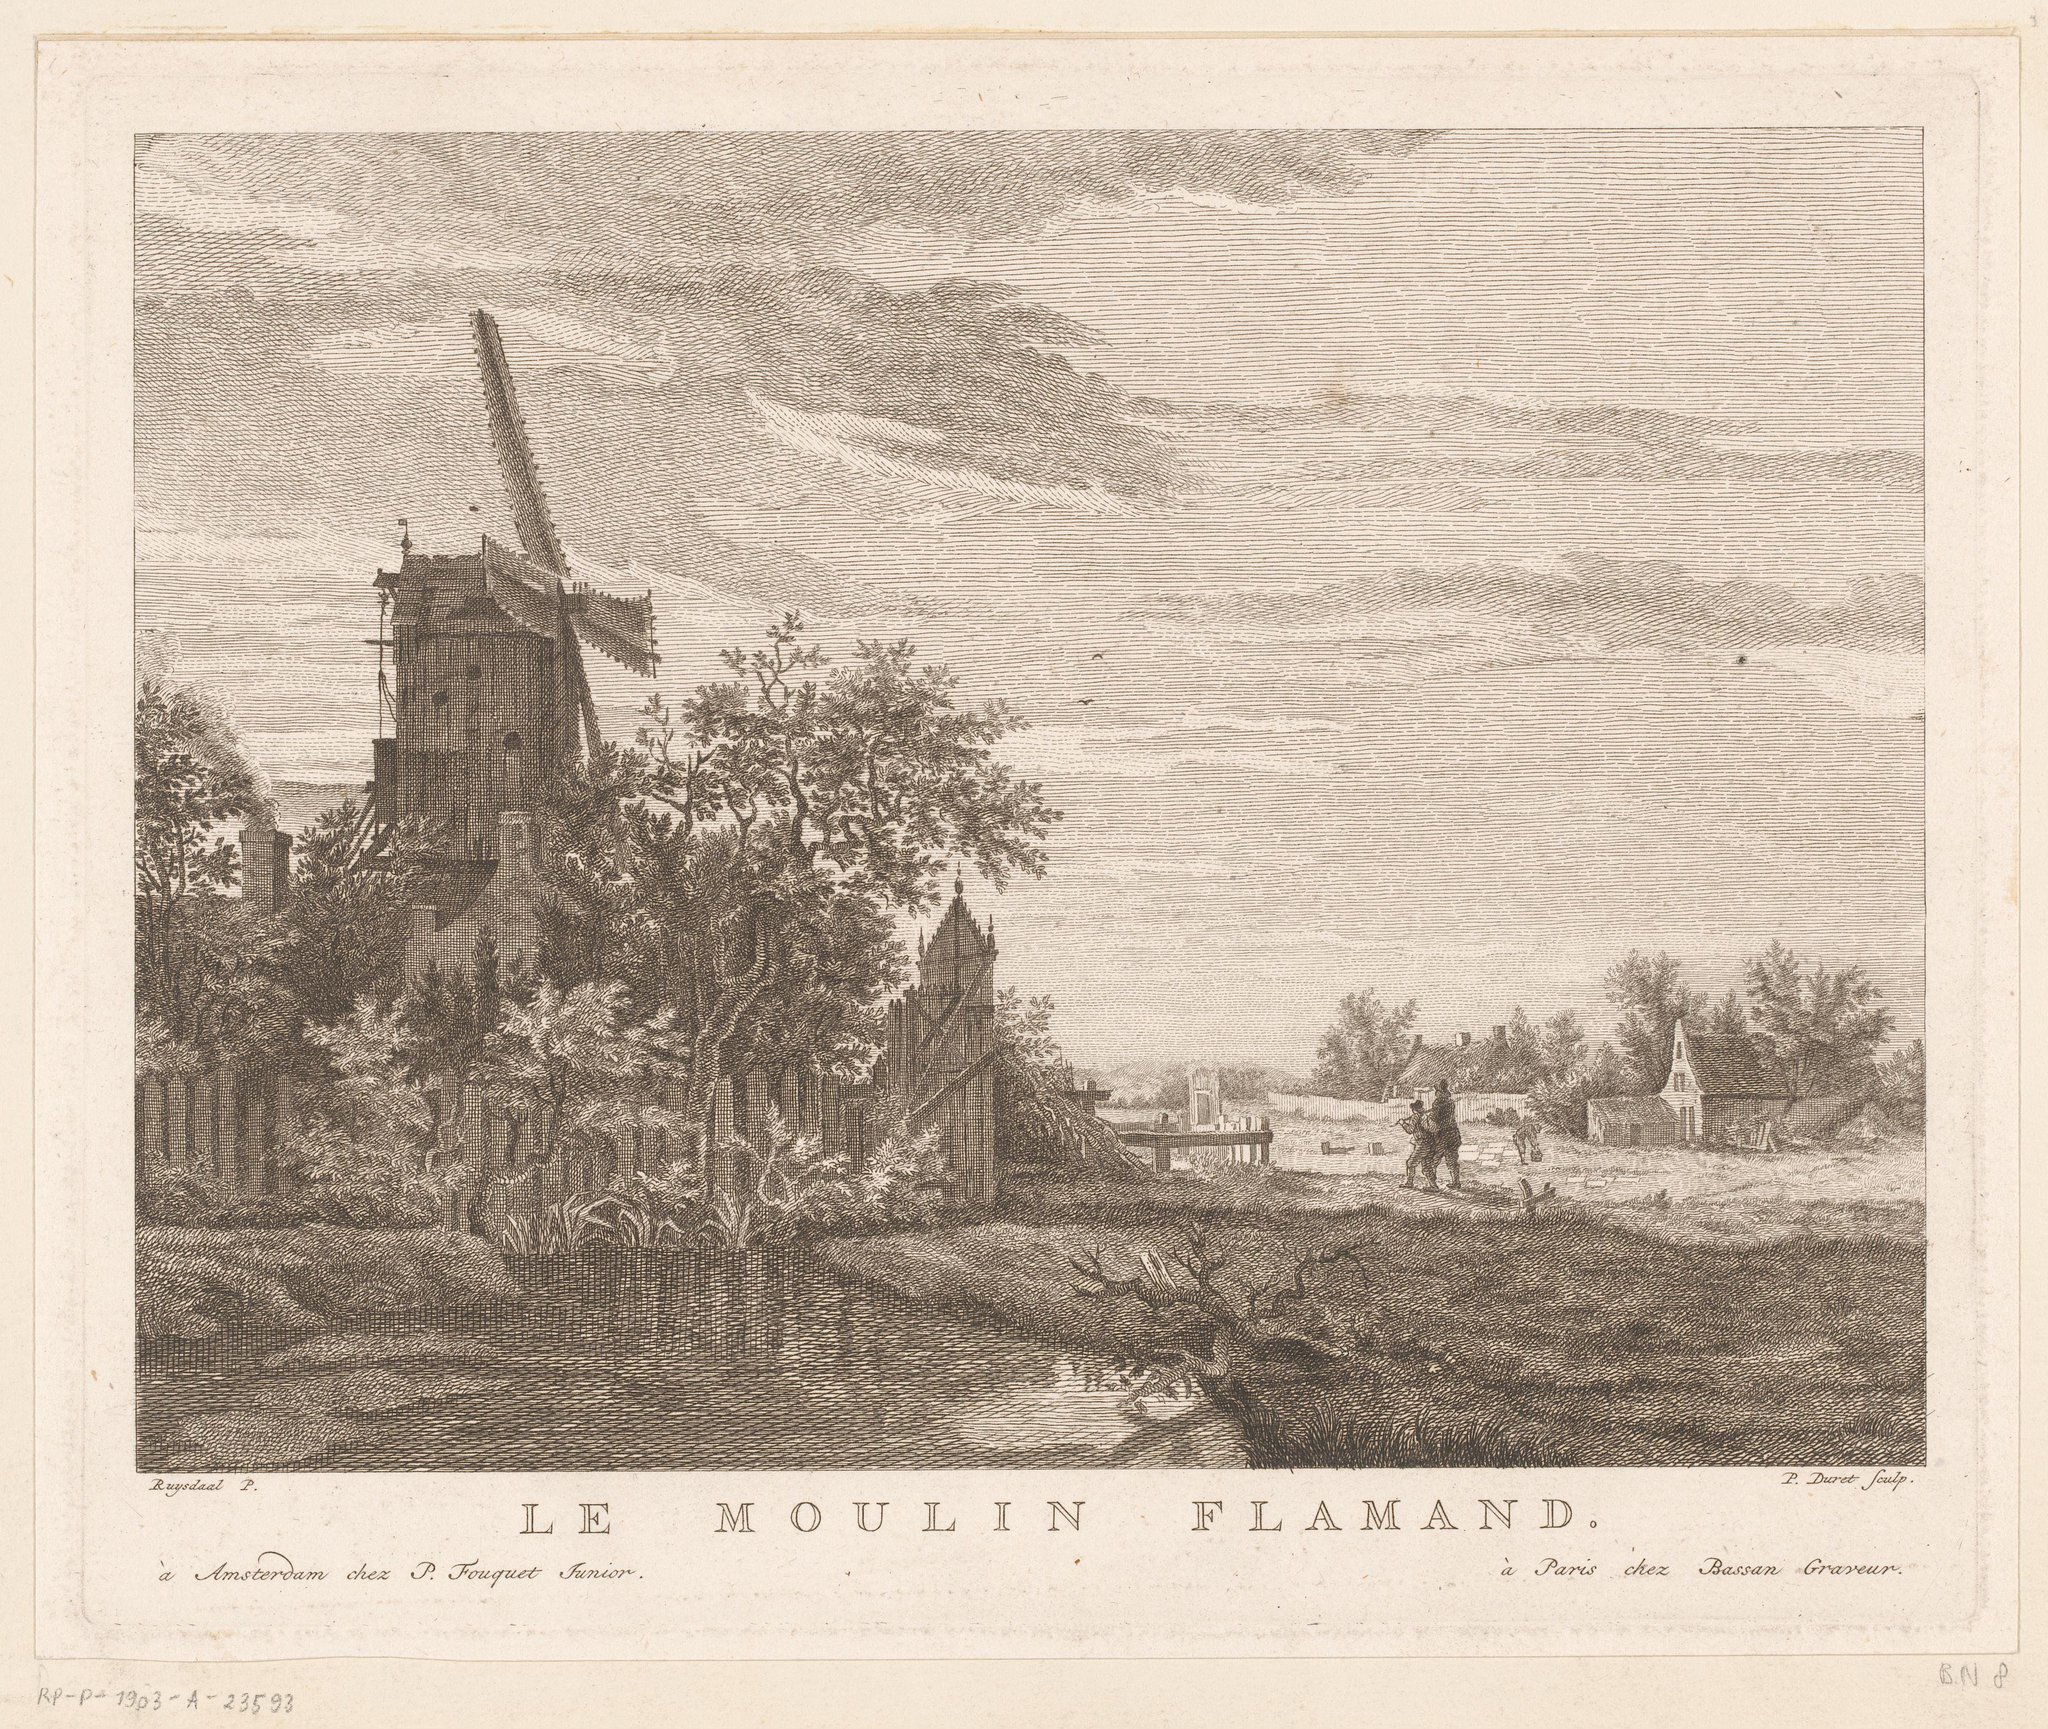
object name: print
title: Landschap met windmolen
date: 1762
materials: paper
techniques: etching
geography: amsterdam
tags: windmill in landscape